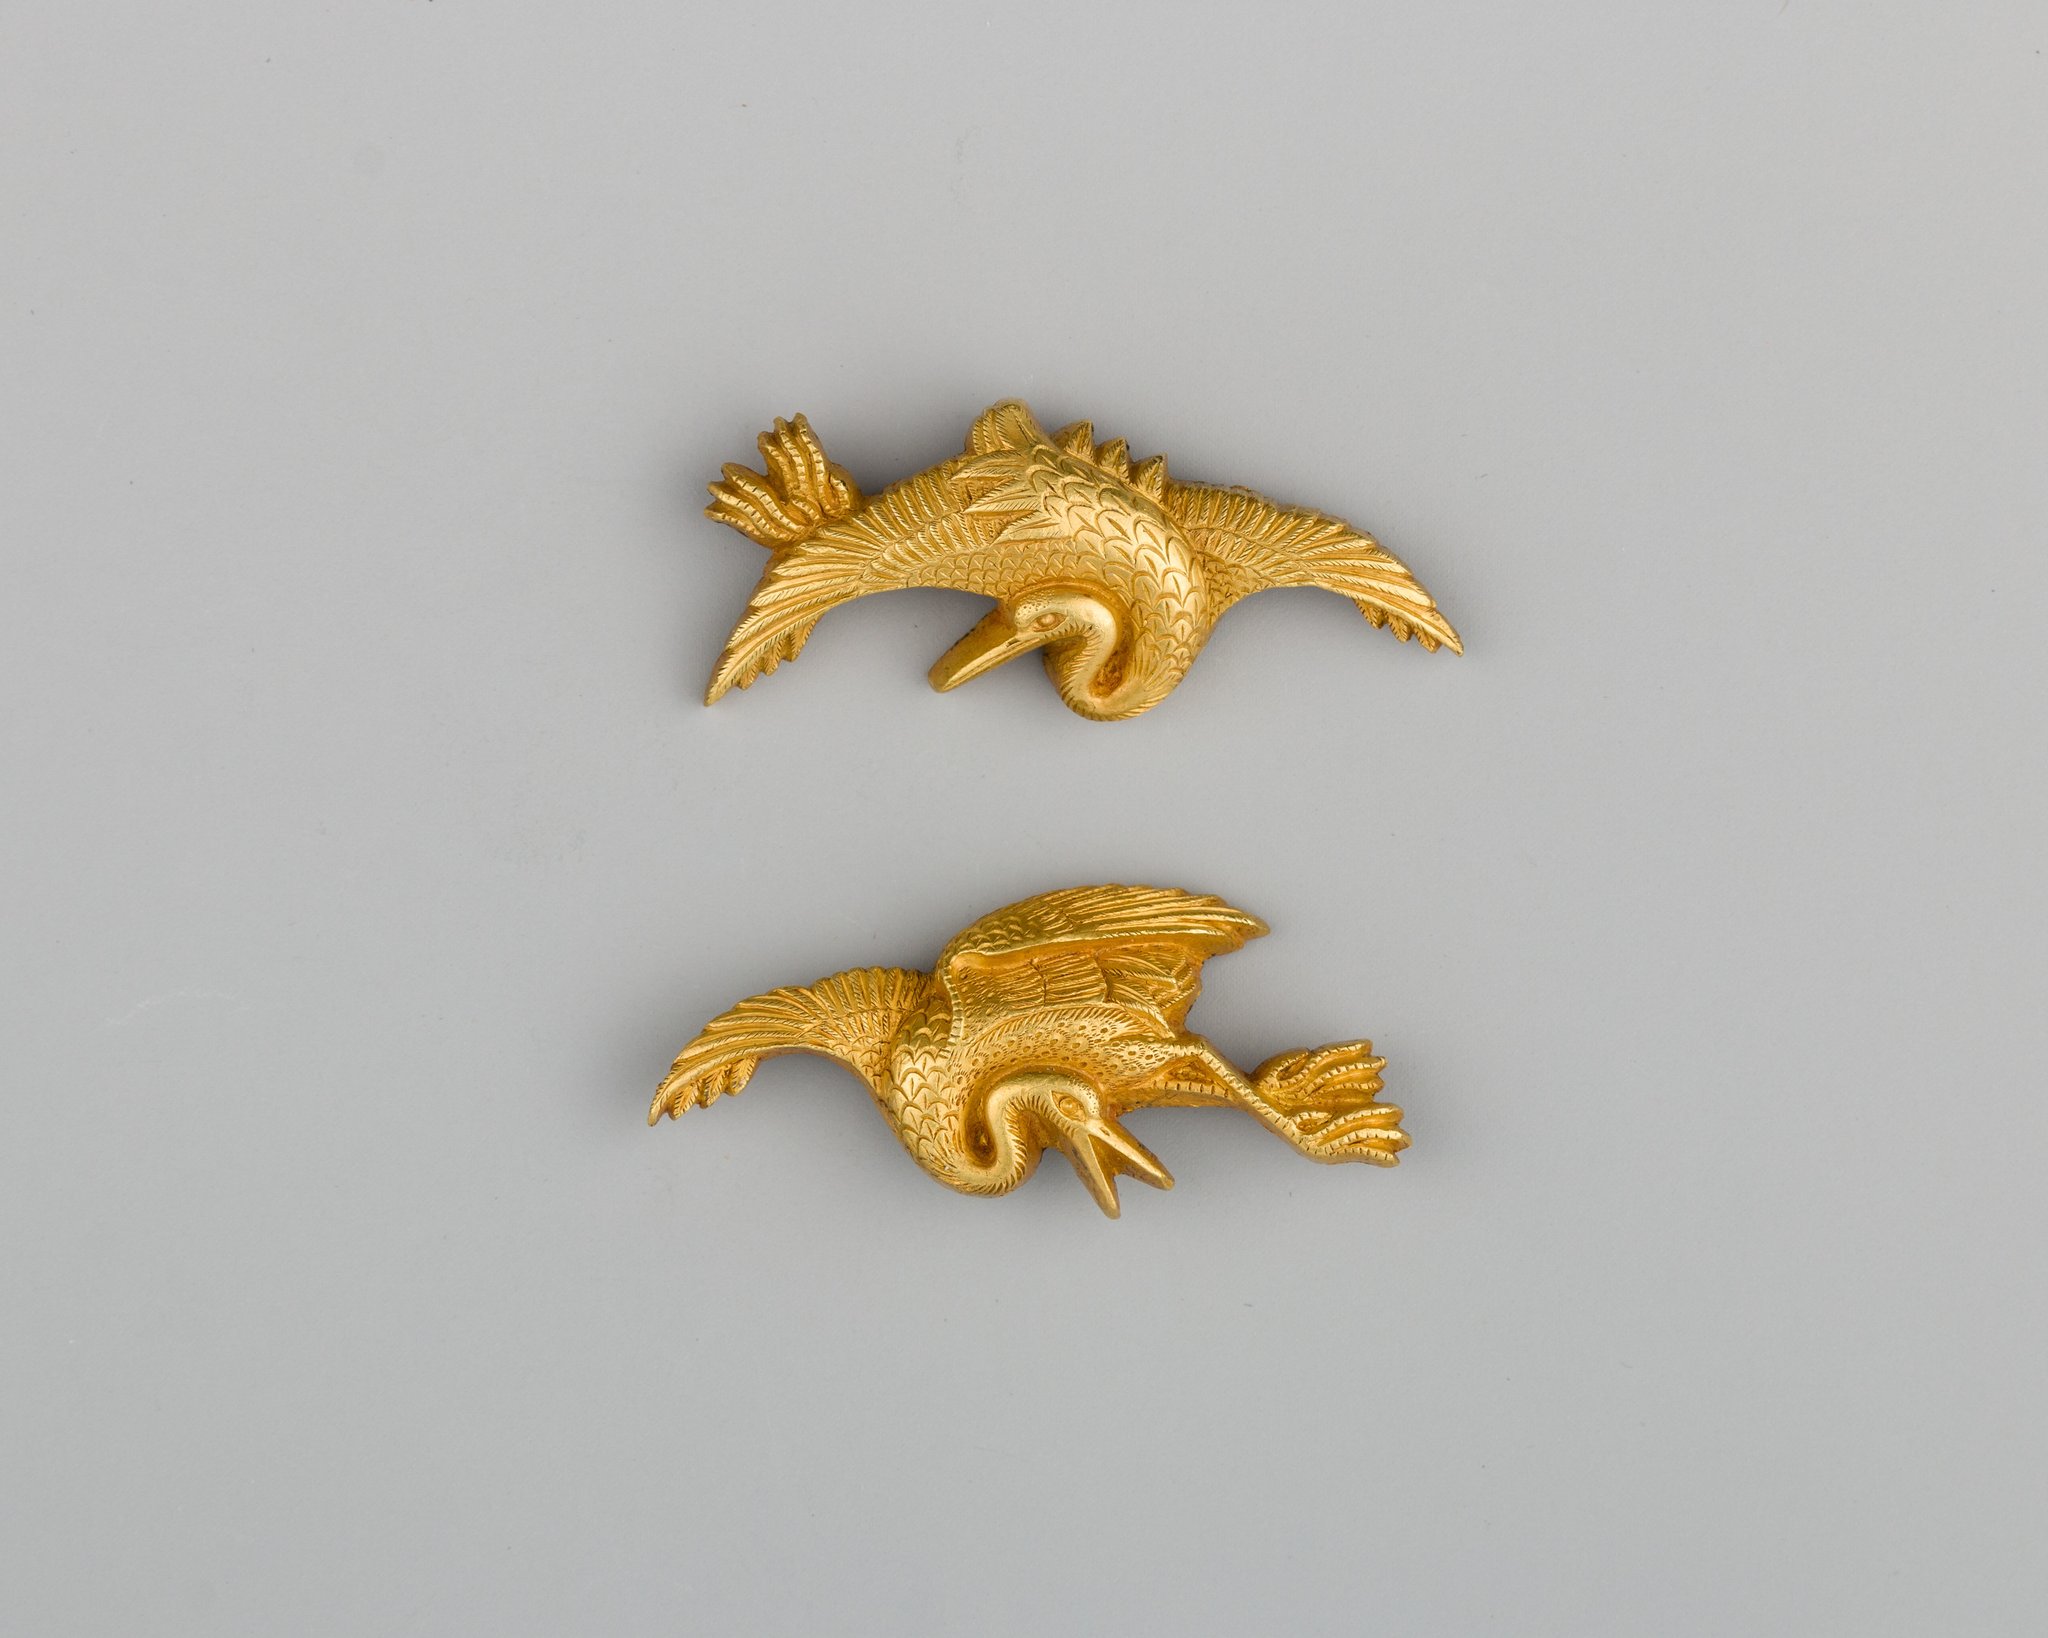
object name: pair of sword grip ornament menuki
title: Pair of Sword-Grip Ornaments (Menuki)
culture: japanese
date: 1701-1800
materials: gold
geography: japan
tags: birds